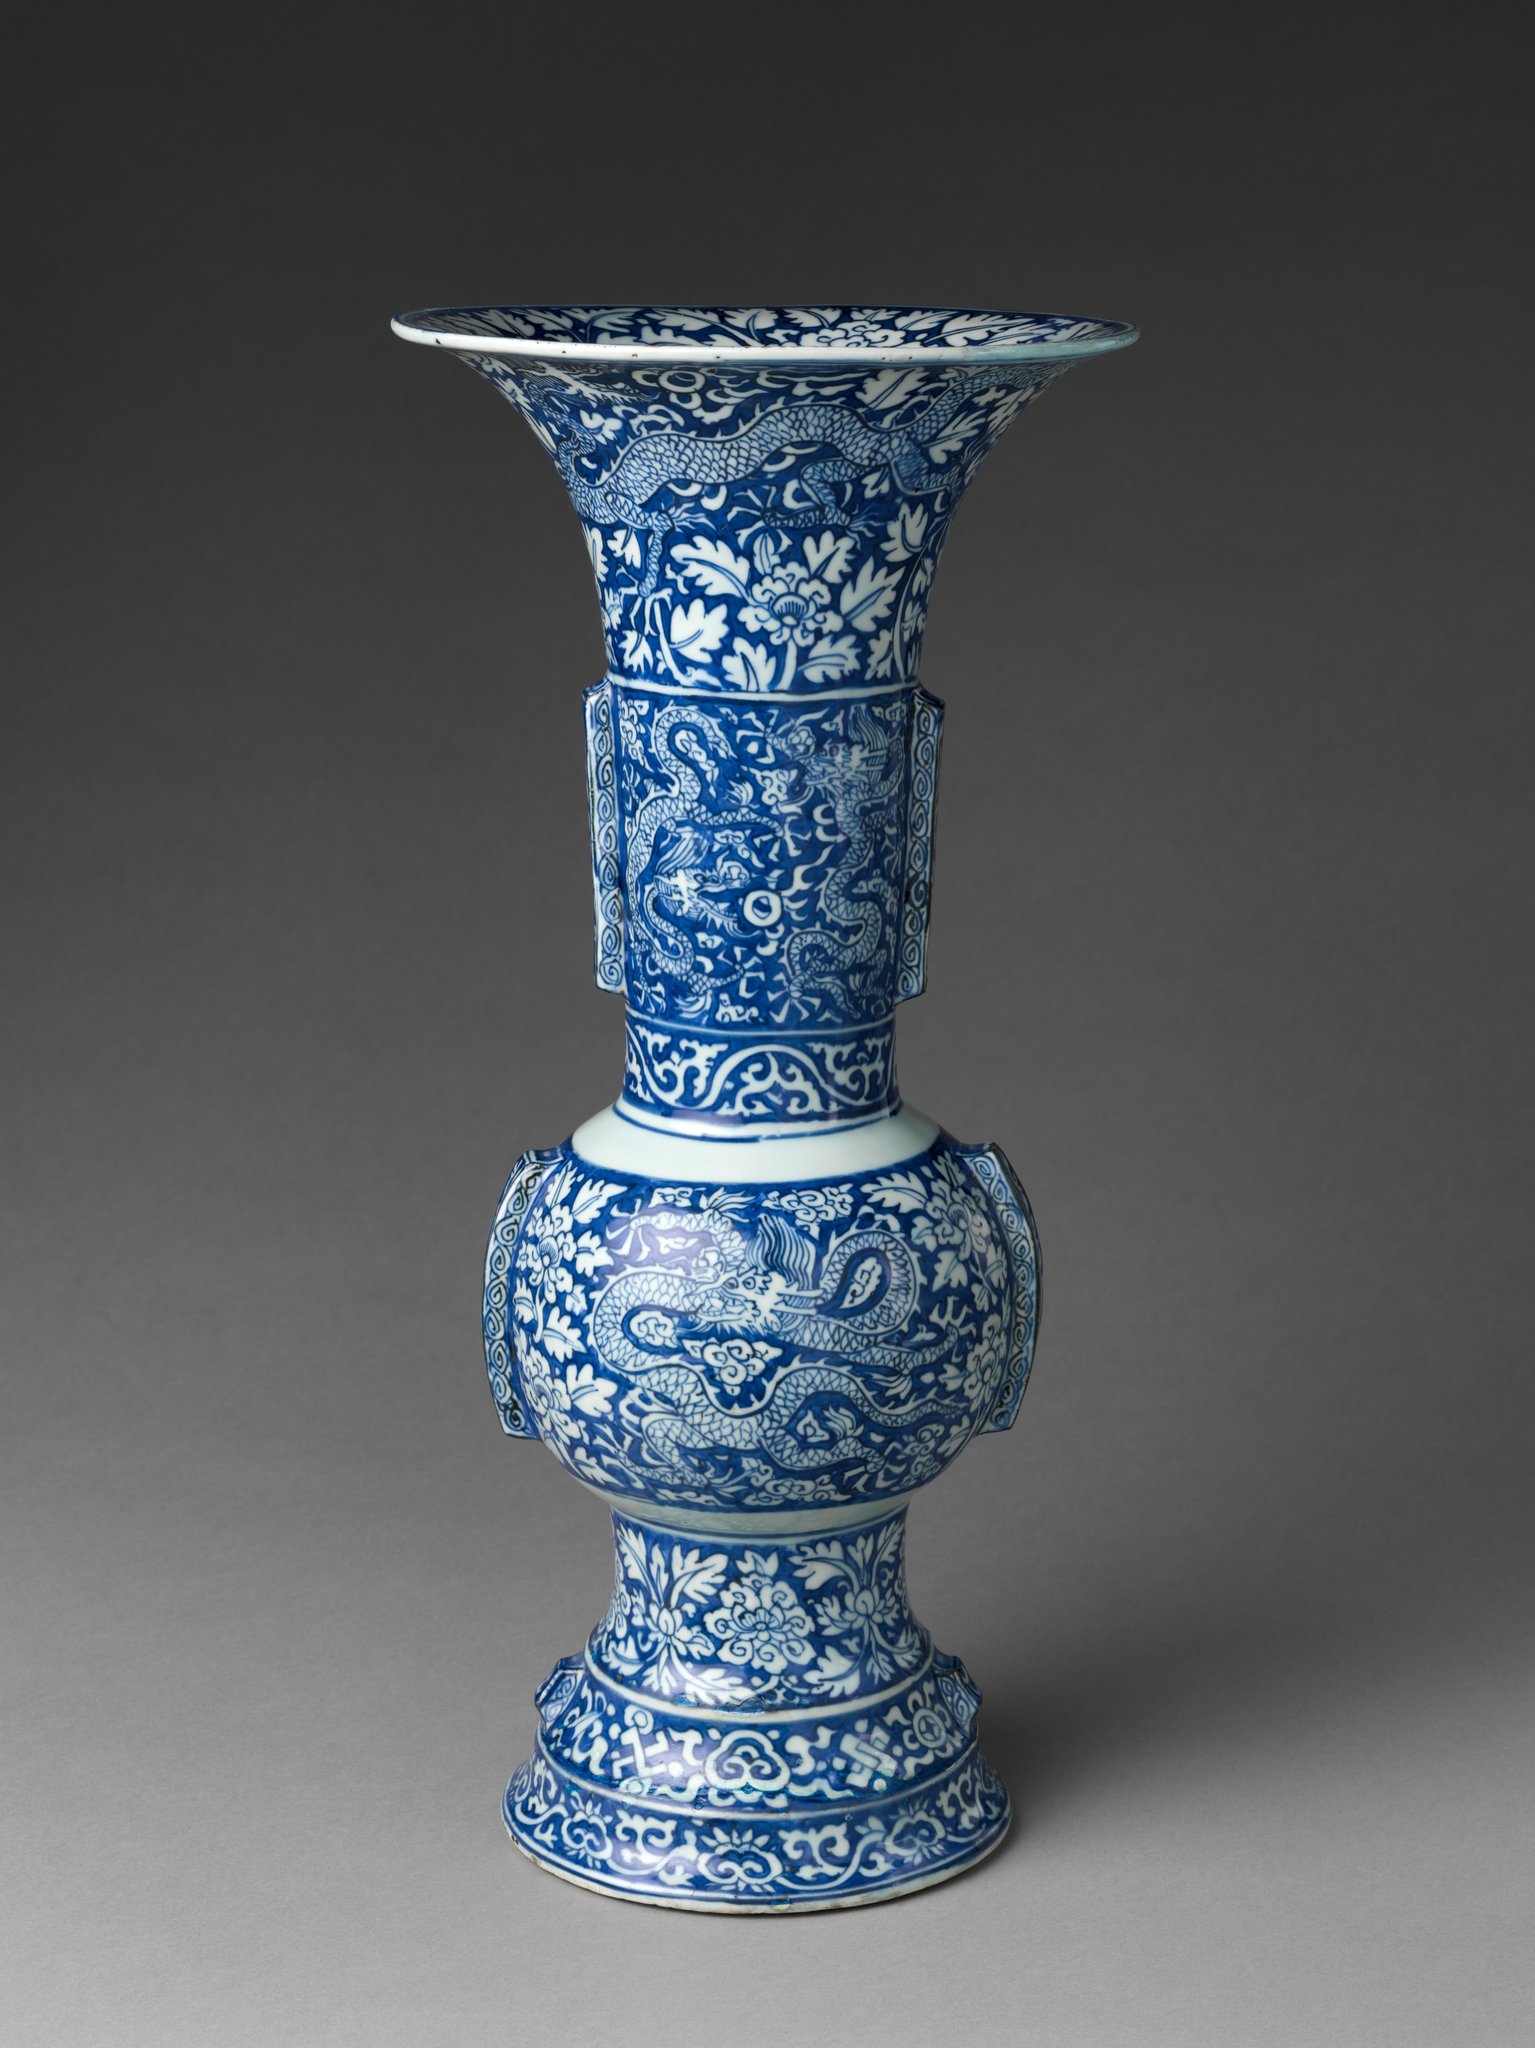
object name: vase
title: Vase with dragons amid flowers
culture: chinese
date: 1567-1633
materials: cobalt, glaze, porcelain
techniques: painting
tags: dragons,flowers